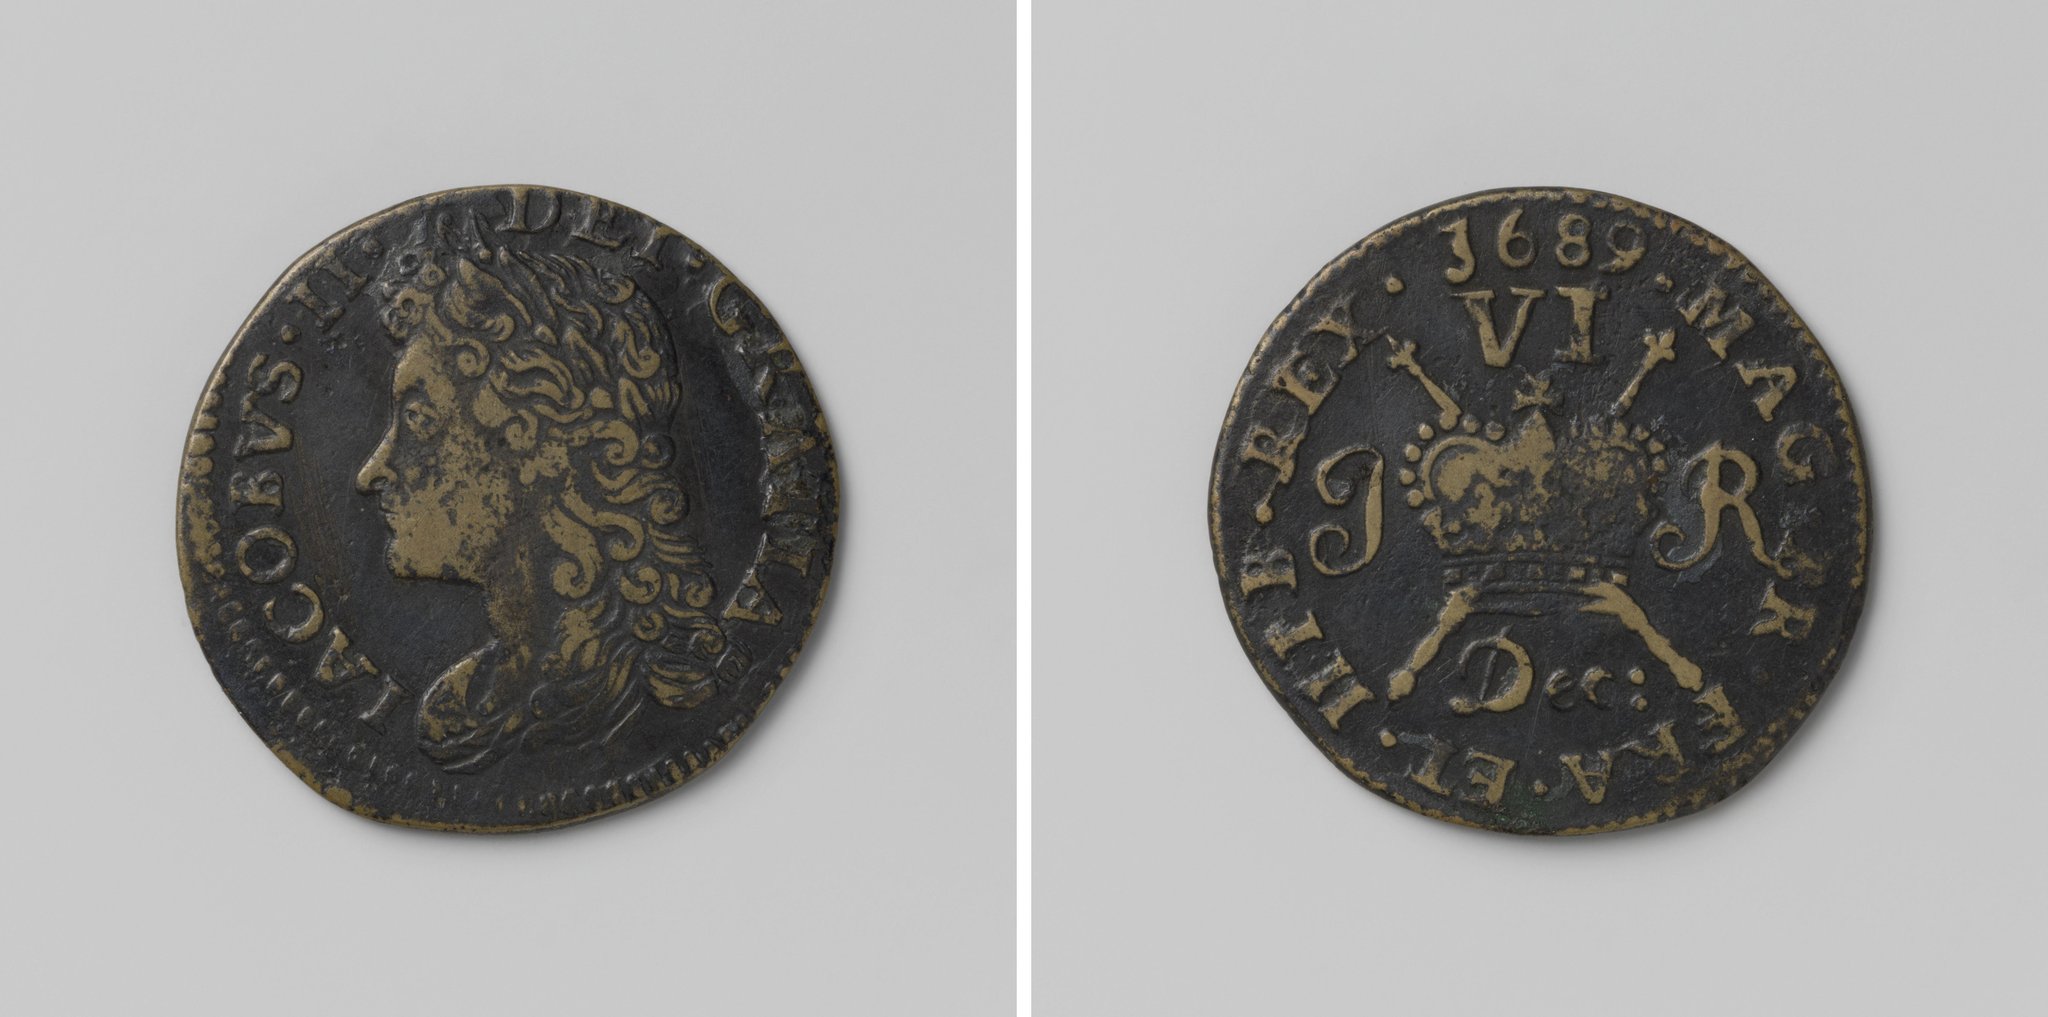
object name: z penny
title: Zes pence, noodmunt van Jacobus II, koning van Engeland, uit december 1689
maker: Anonymous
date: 1612-1689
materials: copper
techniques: striking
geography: ireland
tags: jacobus ii (koning van engeland en schotland)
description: Voorzijde: borststuk man met lauwerkrans binnen omschrift. Keerzijde: kroon, waardoor twee gekruiste scepters steken tussen monogram van letters J en R; boven kroon Romeinse cijfer XXX, onder kroon opschrift "Dec: " binnen omschrift